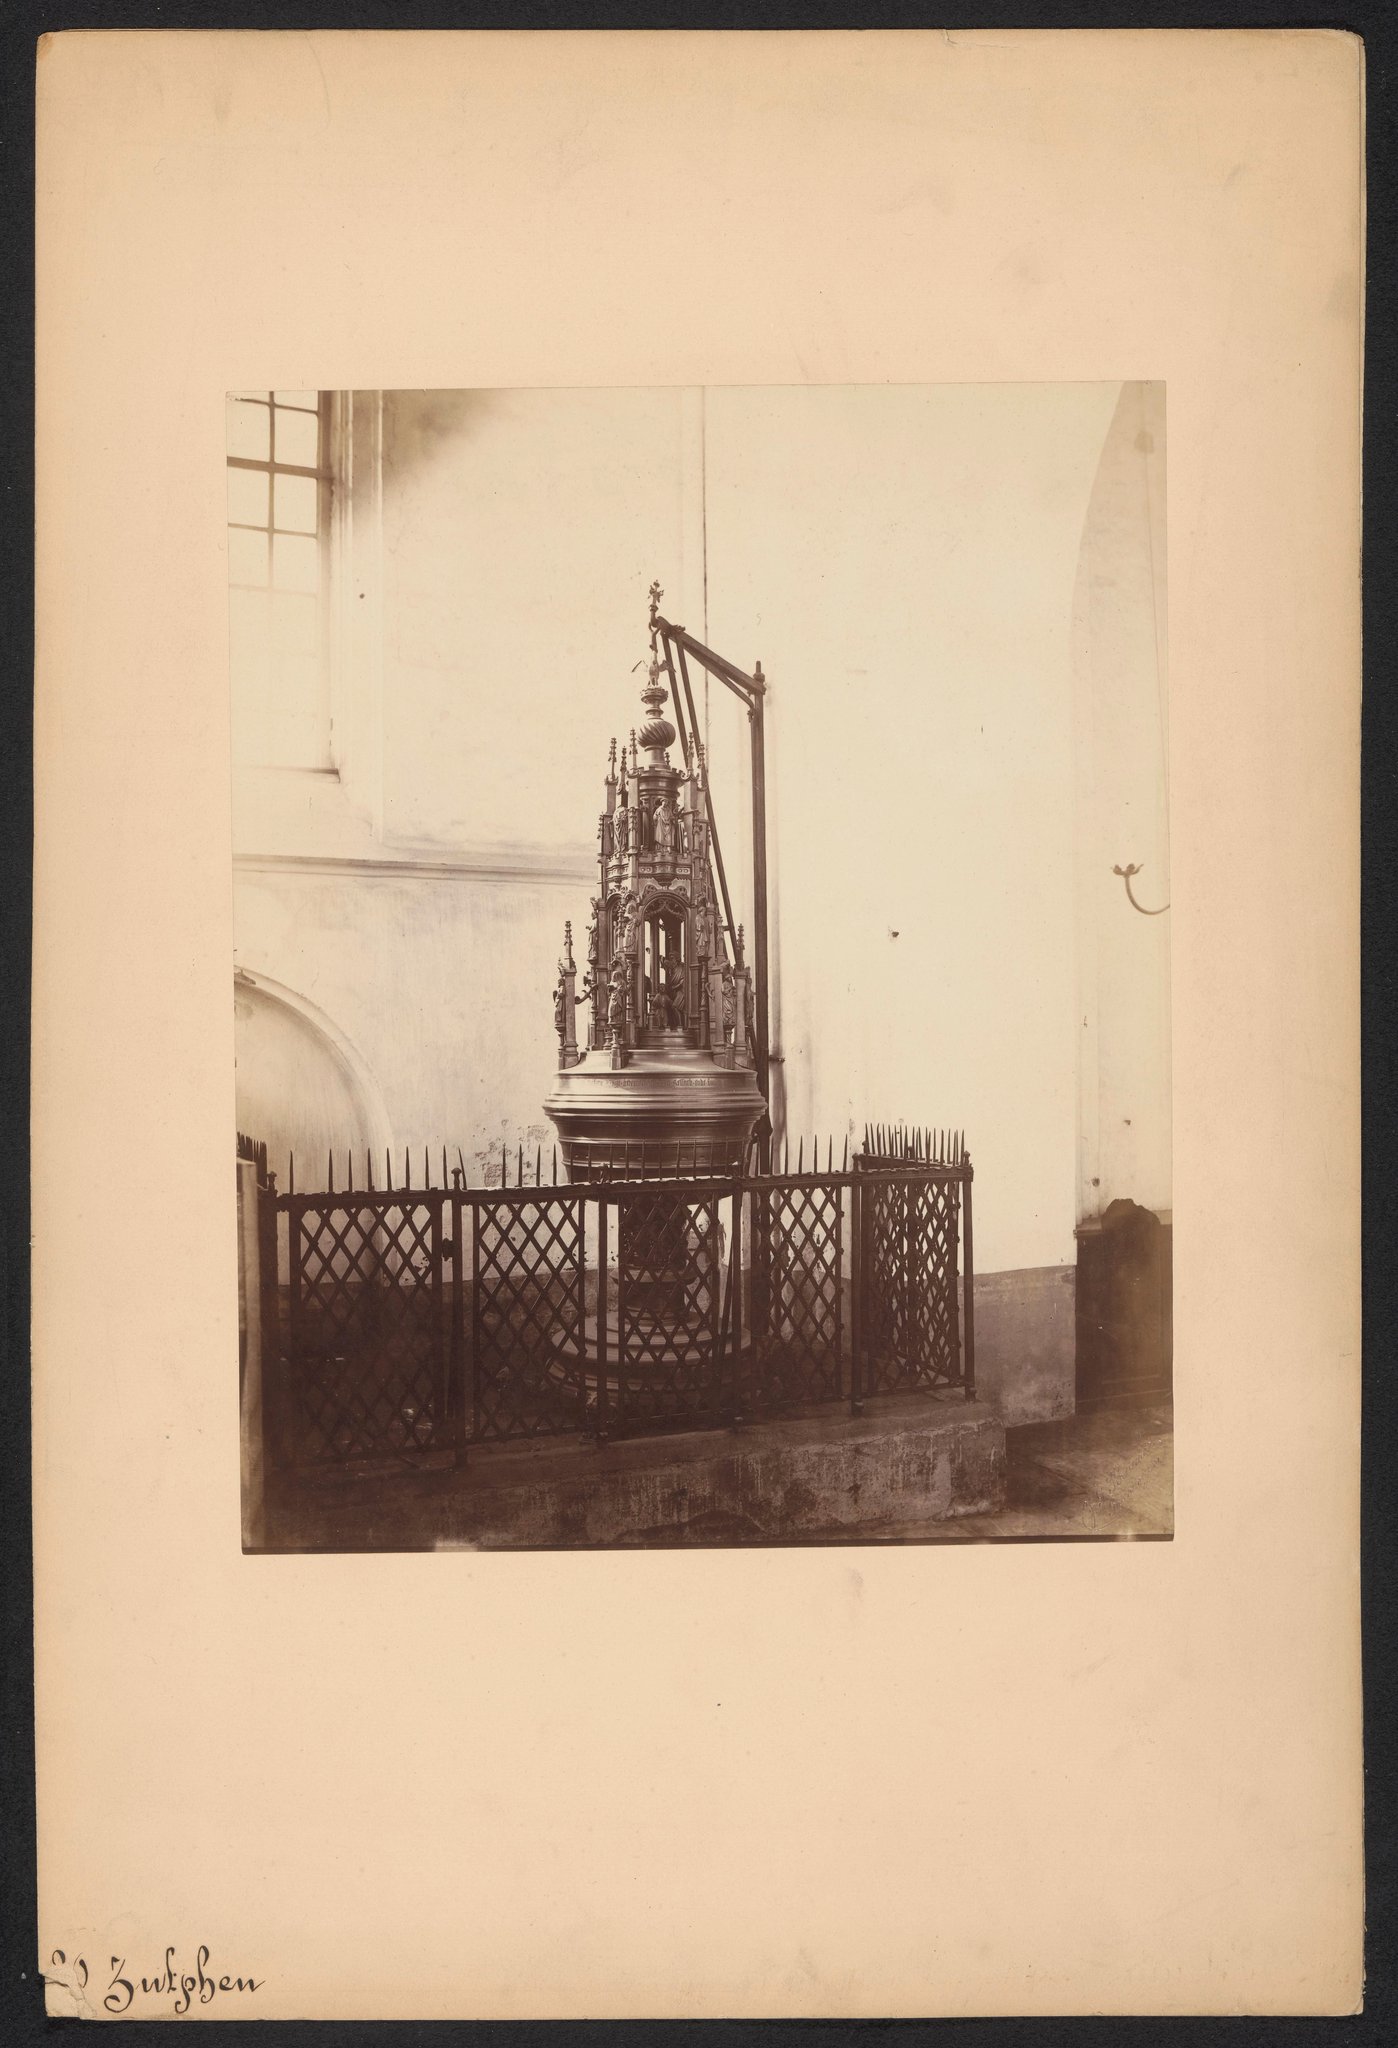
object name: photograph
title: Doopvont in de Walburgiskerk te Zutphen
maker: johannes gerardus kramer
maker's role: fotograaf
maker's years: 1845-1903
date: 1875-1900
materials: cardboard, photographic support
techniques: albumen print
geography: walburgiskerk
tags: fence, wall, paling, interior of church, baptismal font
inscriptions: number: ‘[...]0’, collector's mark: Lugt 3937, name: ‘J.G. Kramer Groningen’, inscription: ‘Zutphen’